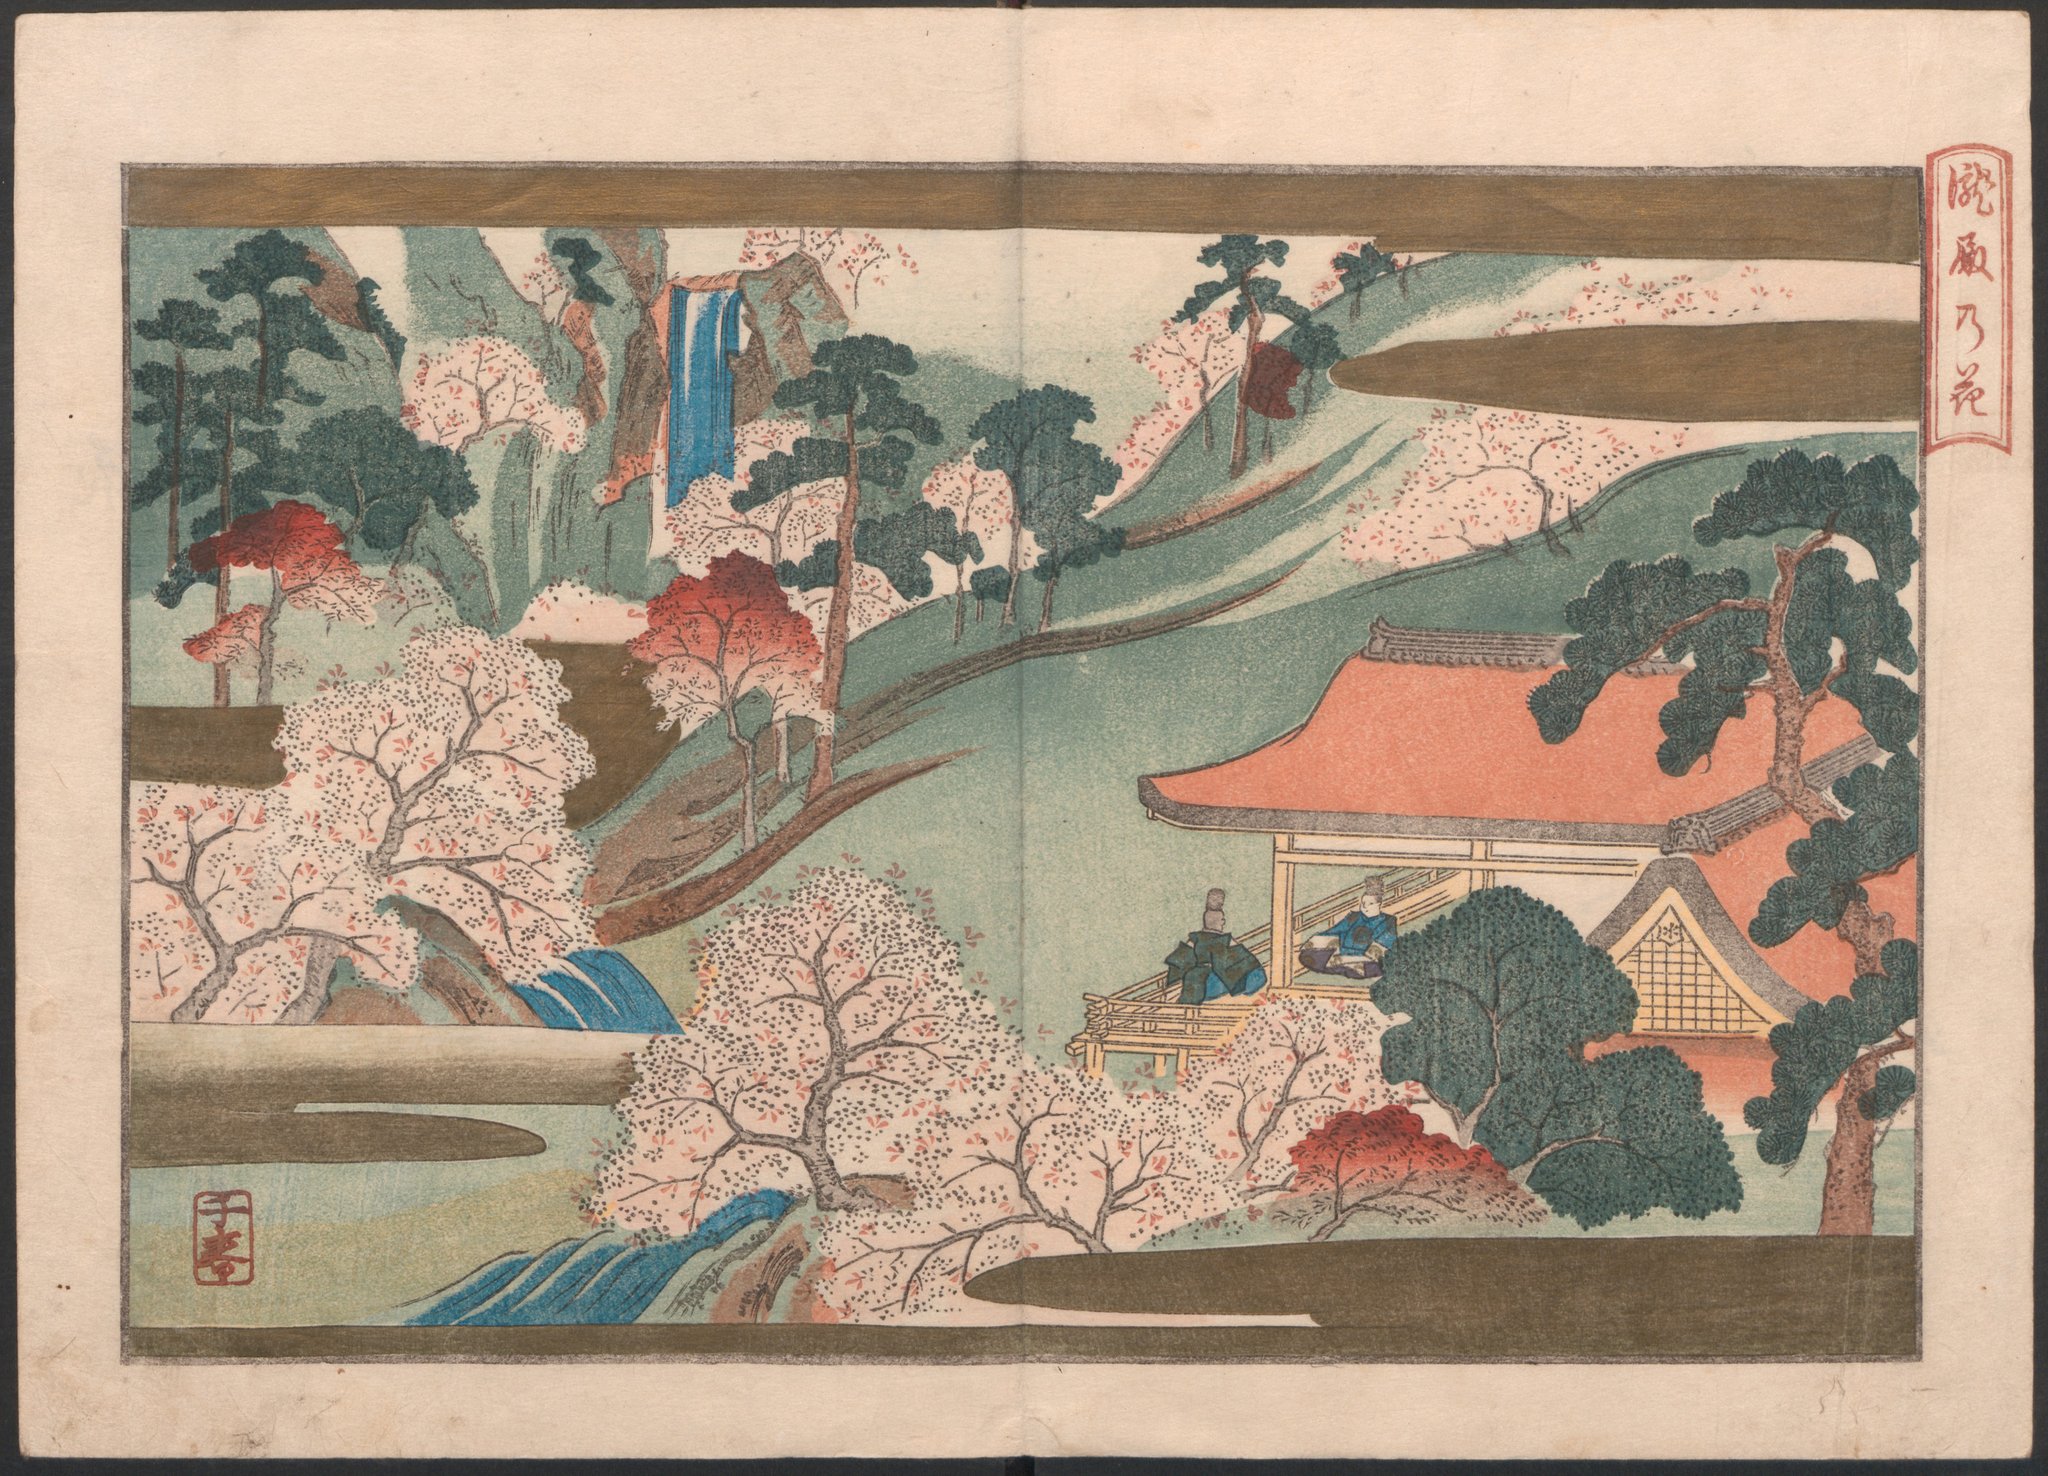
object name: illustrated book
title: Book of Humorous Poems on the Cherry Flower and the Maple Leaves (Ehō no taki) 得吉方廼滝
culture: japanese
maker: totoya hokkei 魚屋北渓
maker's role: artist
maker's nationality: japanese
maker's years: 1780-1850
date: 1833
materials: ink, paper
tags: flowers